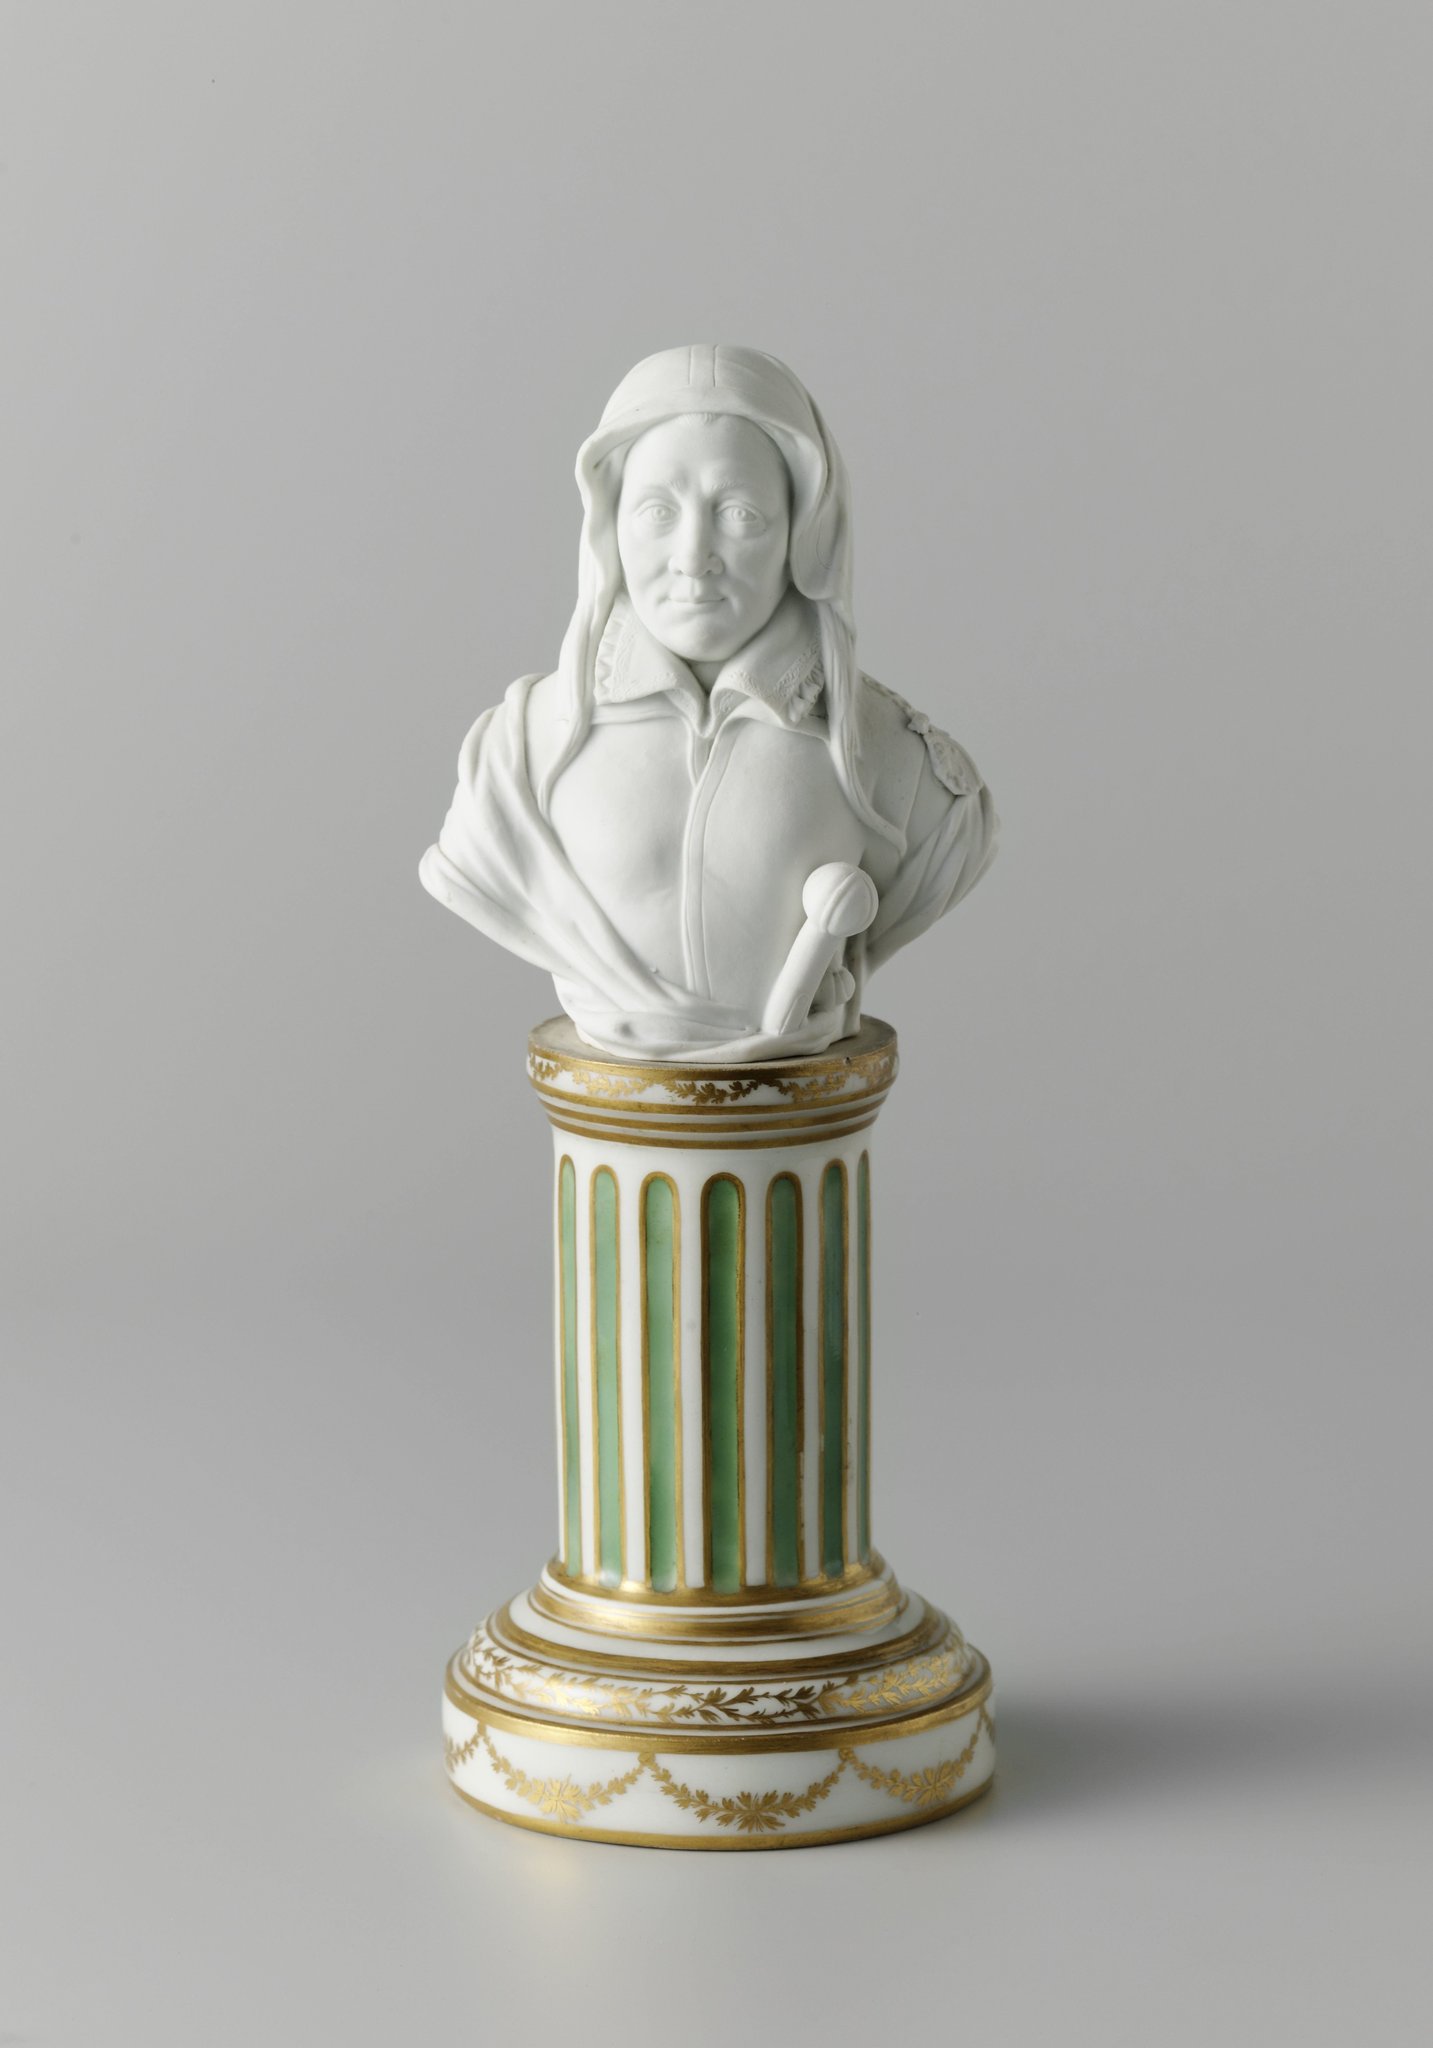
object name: bust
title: Kenau Simonsdr. Hasselaar (1526-1588)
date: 1782-1784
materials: biscuit porcelain, material), porcelain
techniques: biscuit (porcelain, material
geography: loosdrecht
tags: historical persons - bb - woman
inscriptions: factory mark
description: Bust of Kenau Simonsdr Hasselaar (1526 - 1588), on pedestal. Biscuit porcelain. Loosdrecht, c. 1782 - 1784. Factory under the direction of Friedrich Daeuber The bust after a print by J. Houbraken after H. Pothoven. Given by the Belport Familien Stiftung, 1987.